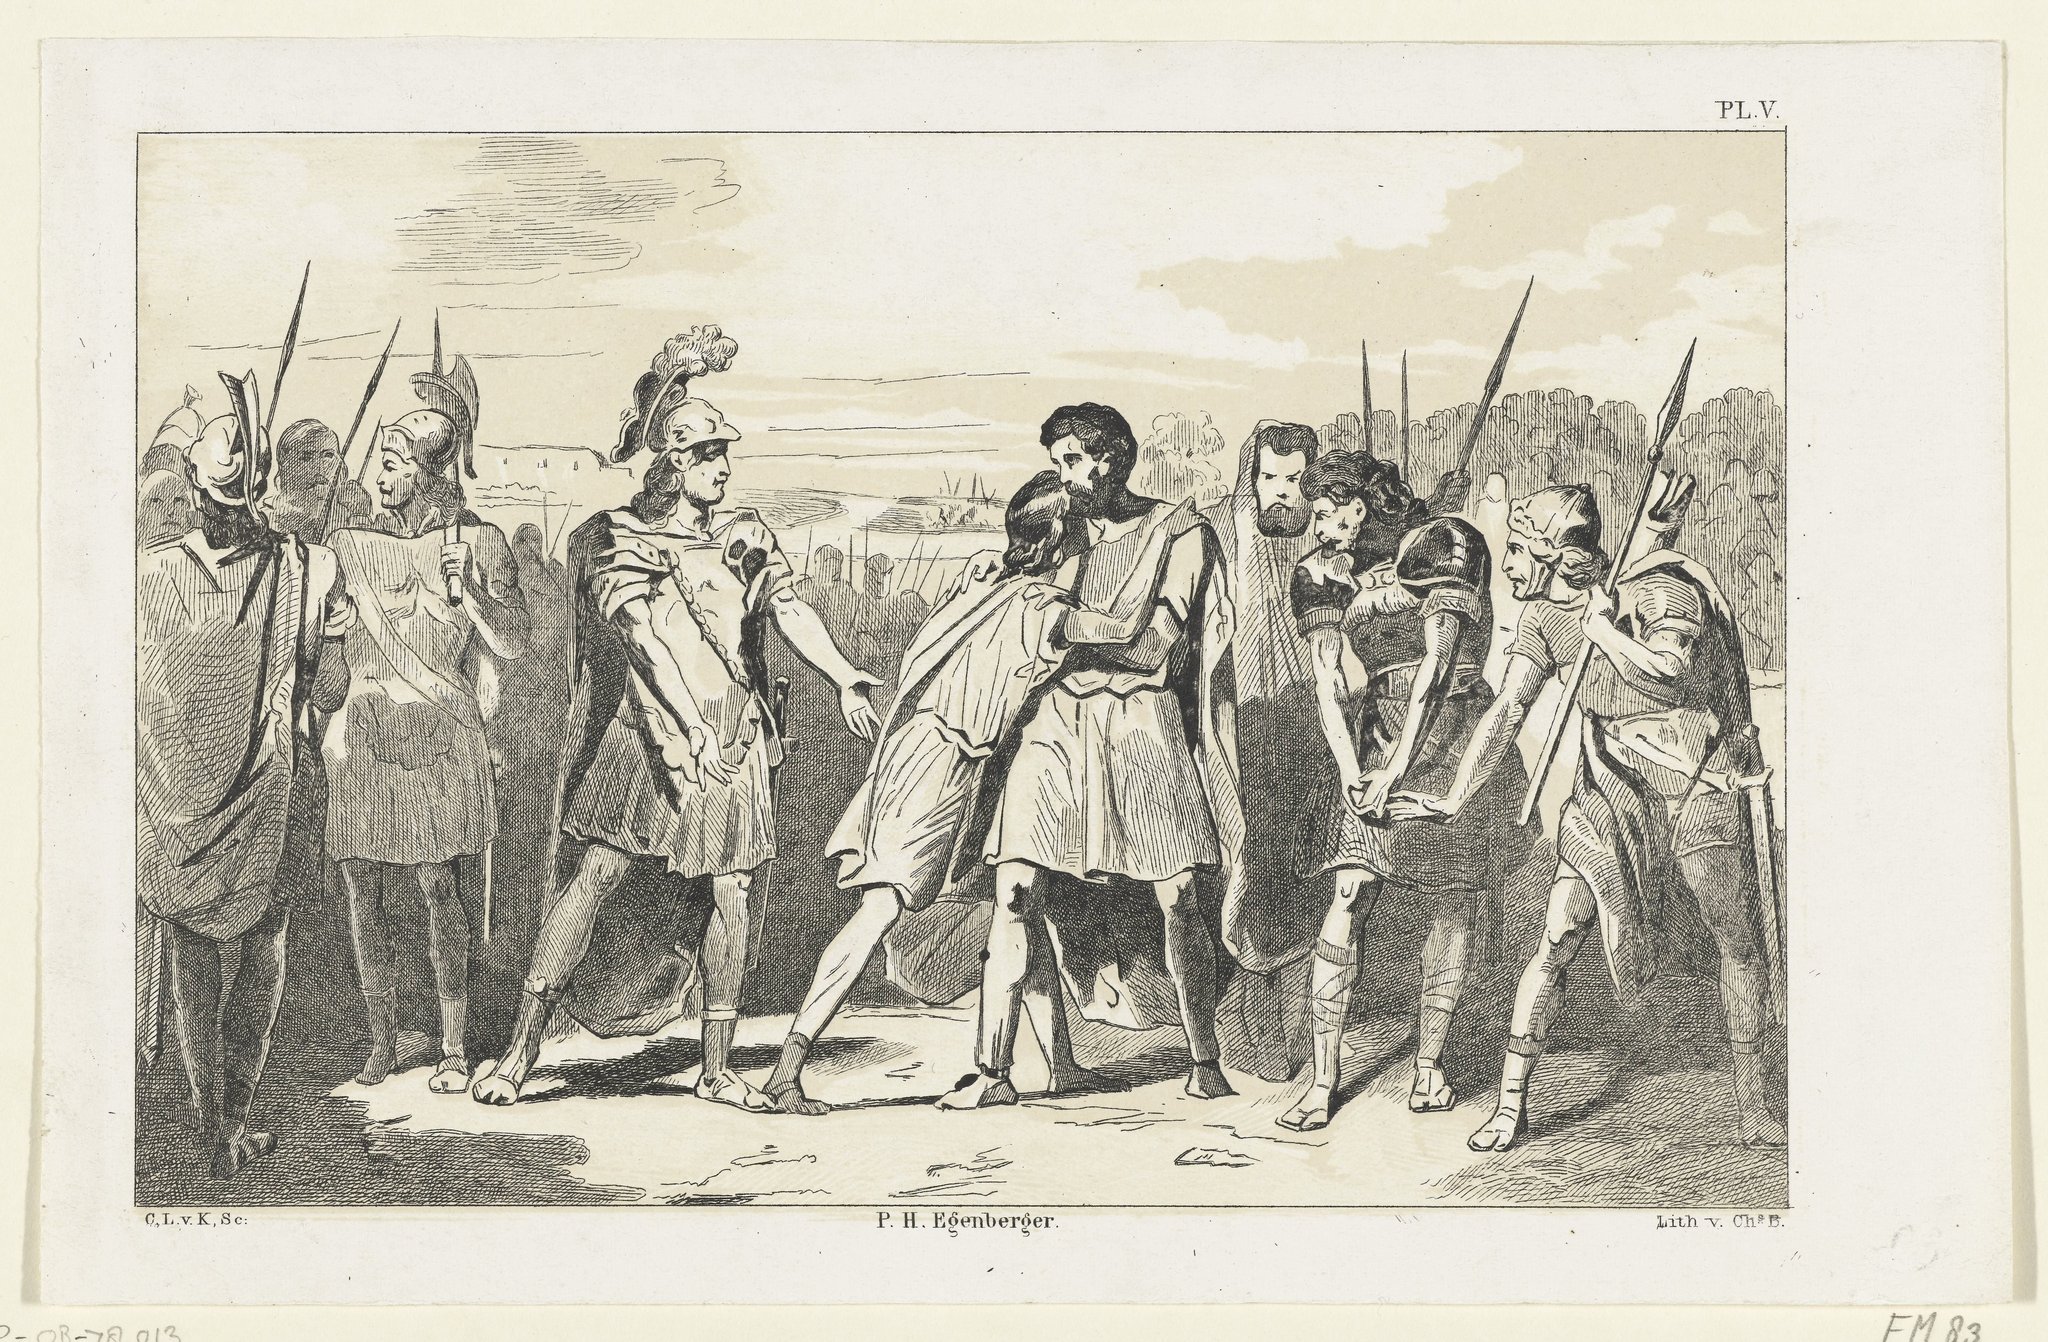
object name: history print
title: Julianus bezorgt de gegijzelde zoon terug bij de leider der Chamaven, ca. 350-363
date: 1853-1861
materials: paper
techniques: lithograph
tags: extinct, 'historical' peoples (with name)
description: Illustratie voor: Jacob van Lennep, De geschiedenis des vaderlands in schetsen en afbeeldingen, Binger, Amsterdam 1855-1861, 8 delen, pl. V.